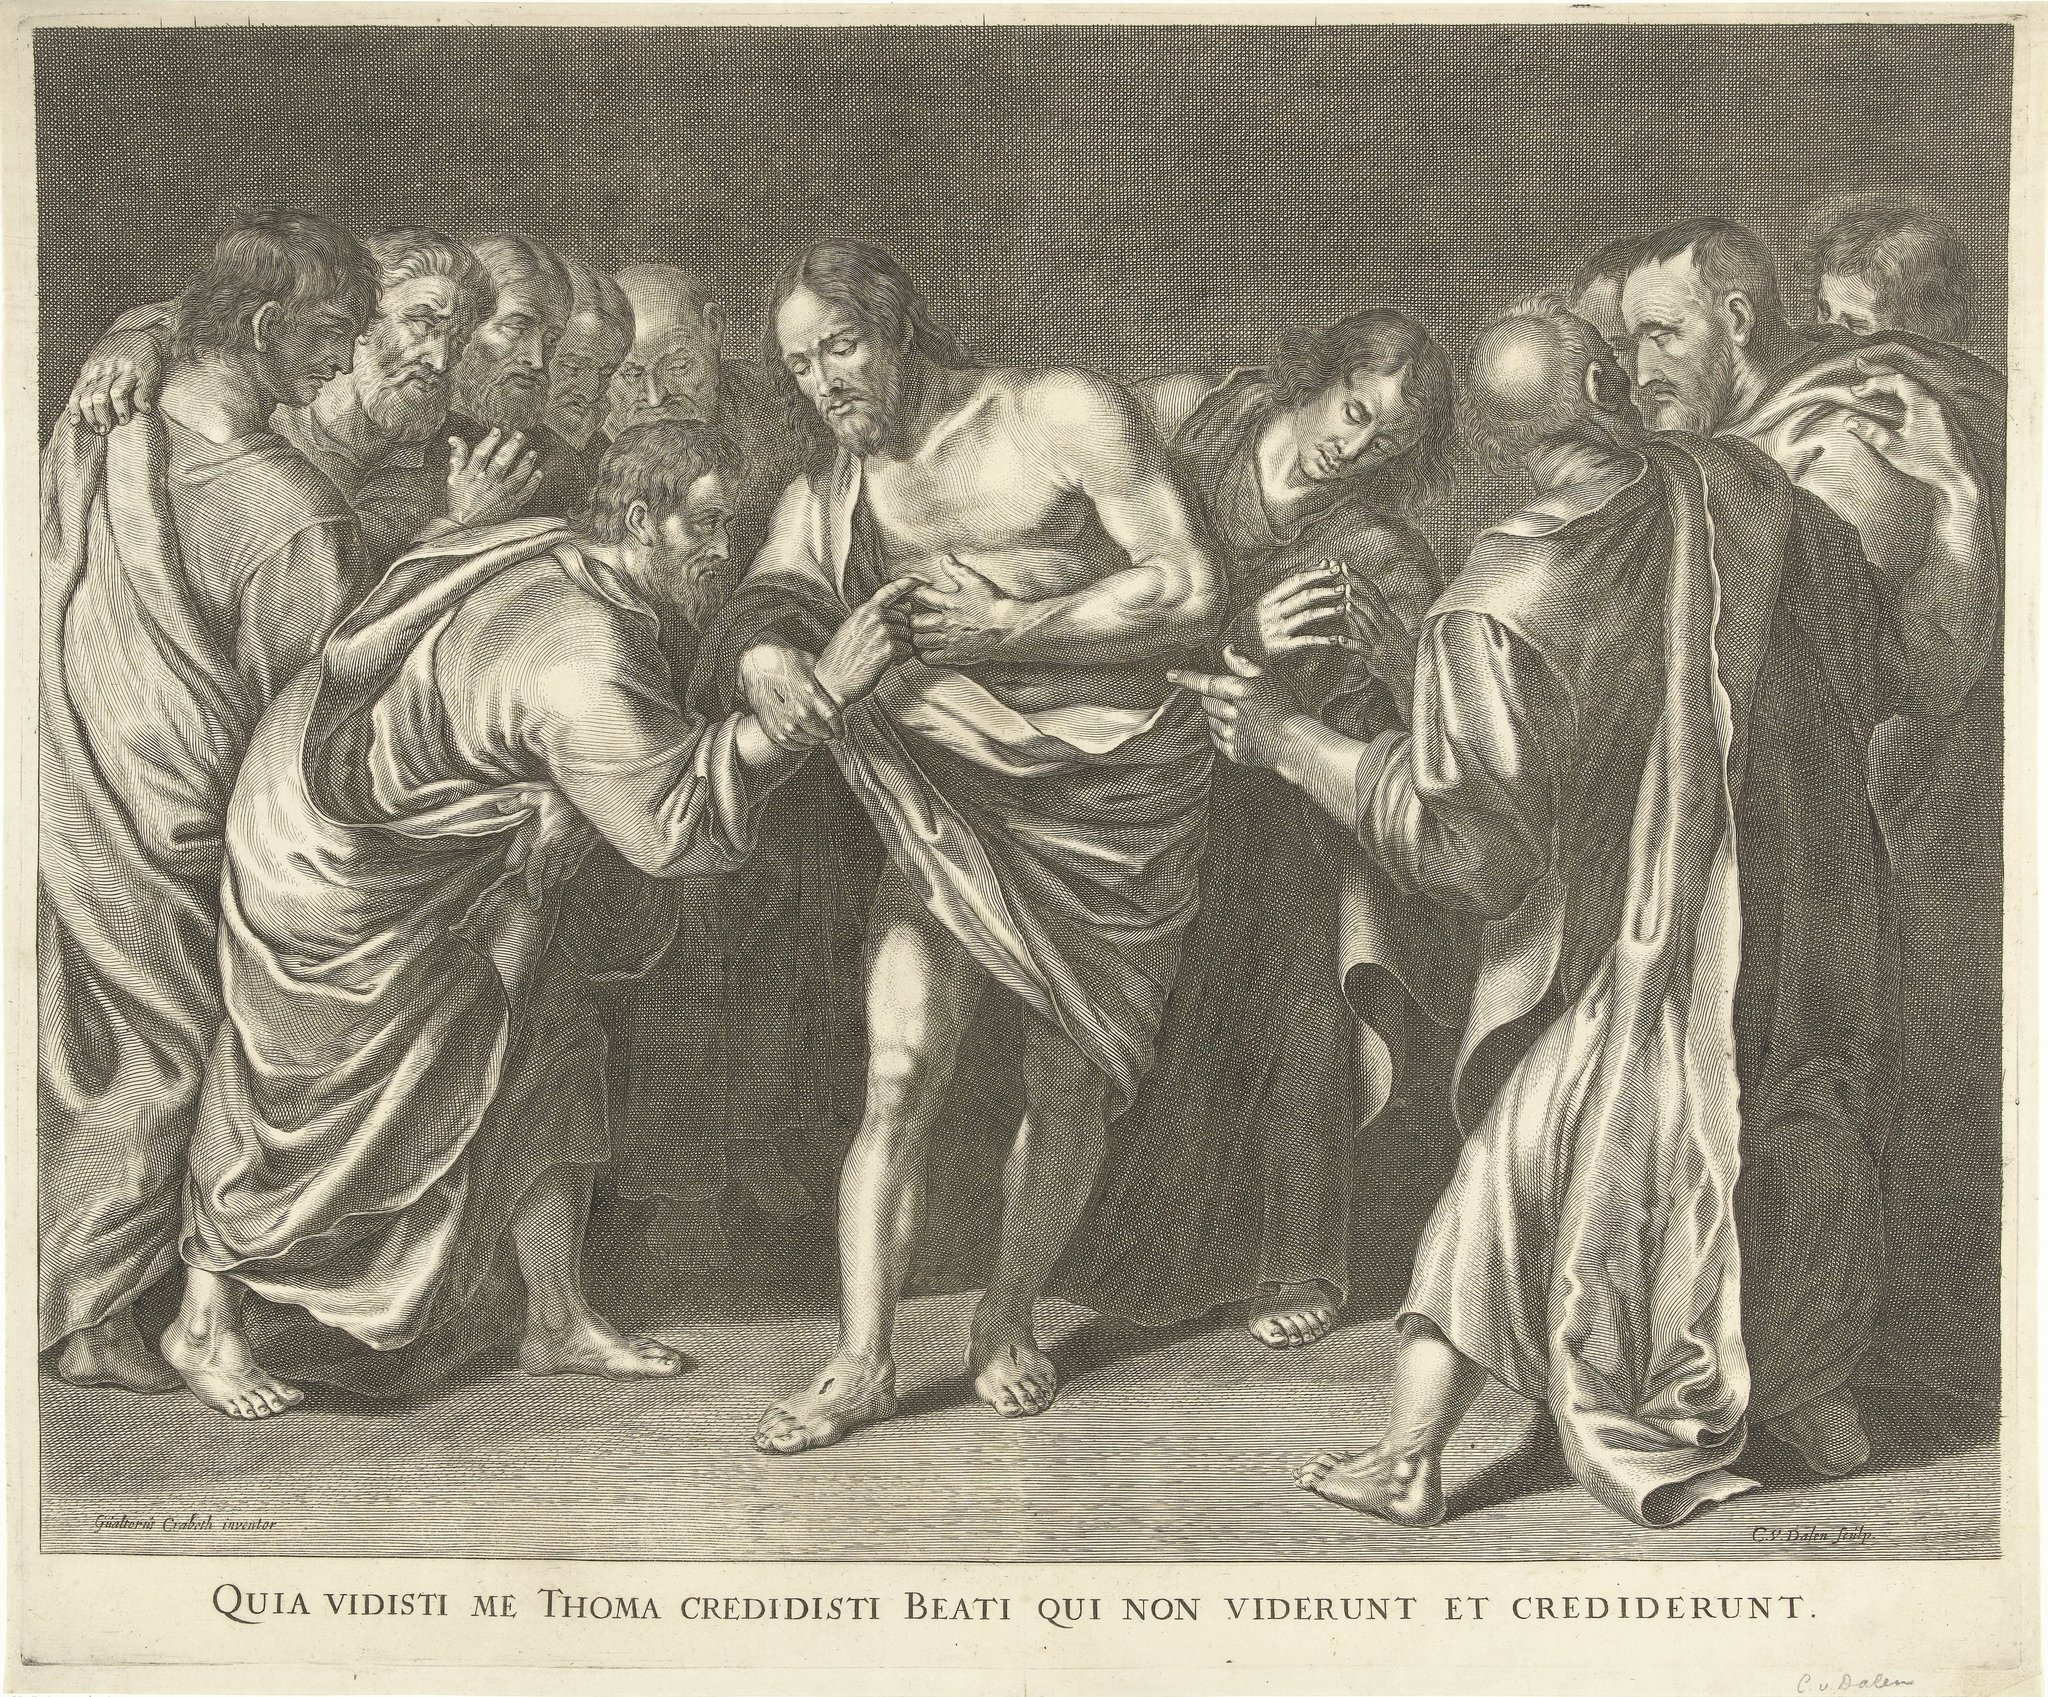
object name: print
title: Ongelovige Thomas raakt Christus' wond aan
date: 1612-1665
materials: paper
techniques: engraving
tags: thomas touching or stretching out his hands to touch the wound in christ's side, sometimes christ leading thomas' hand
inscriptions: collector's mark: Lugt 2228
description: Christus toont Thomas zijn wonden na de kruisiging in aanwezigheid van de andere apostelen.